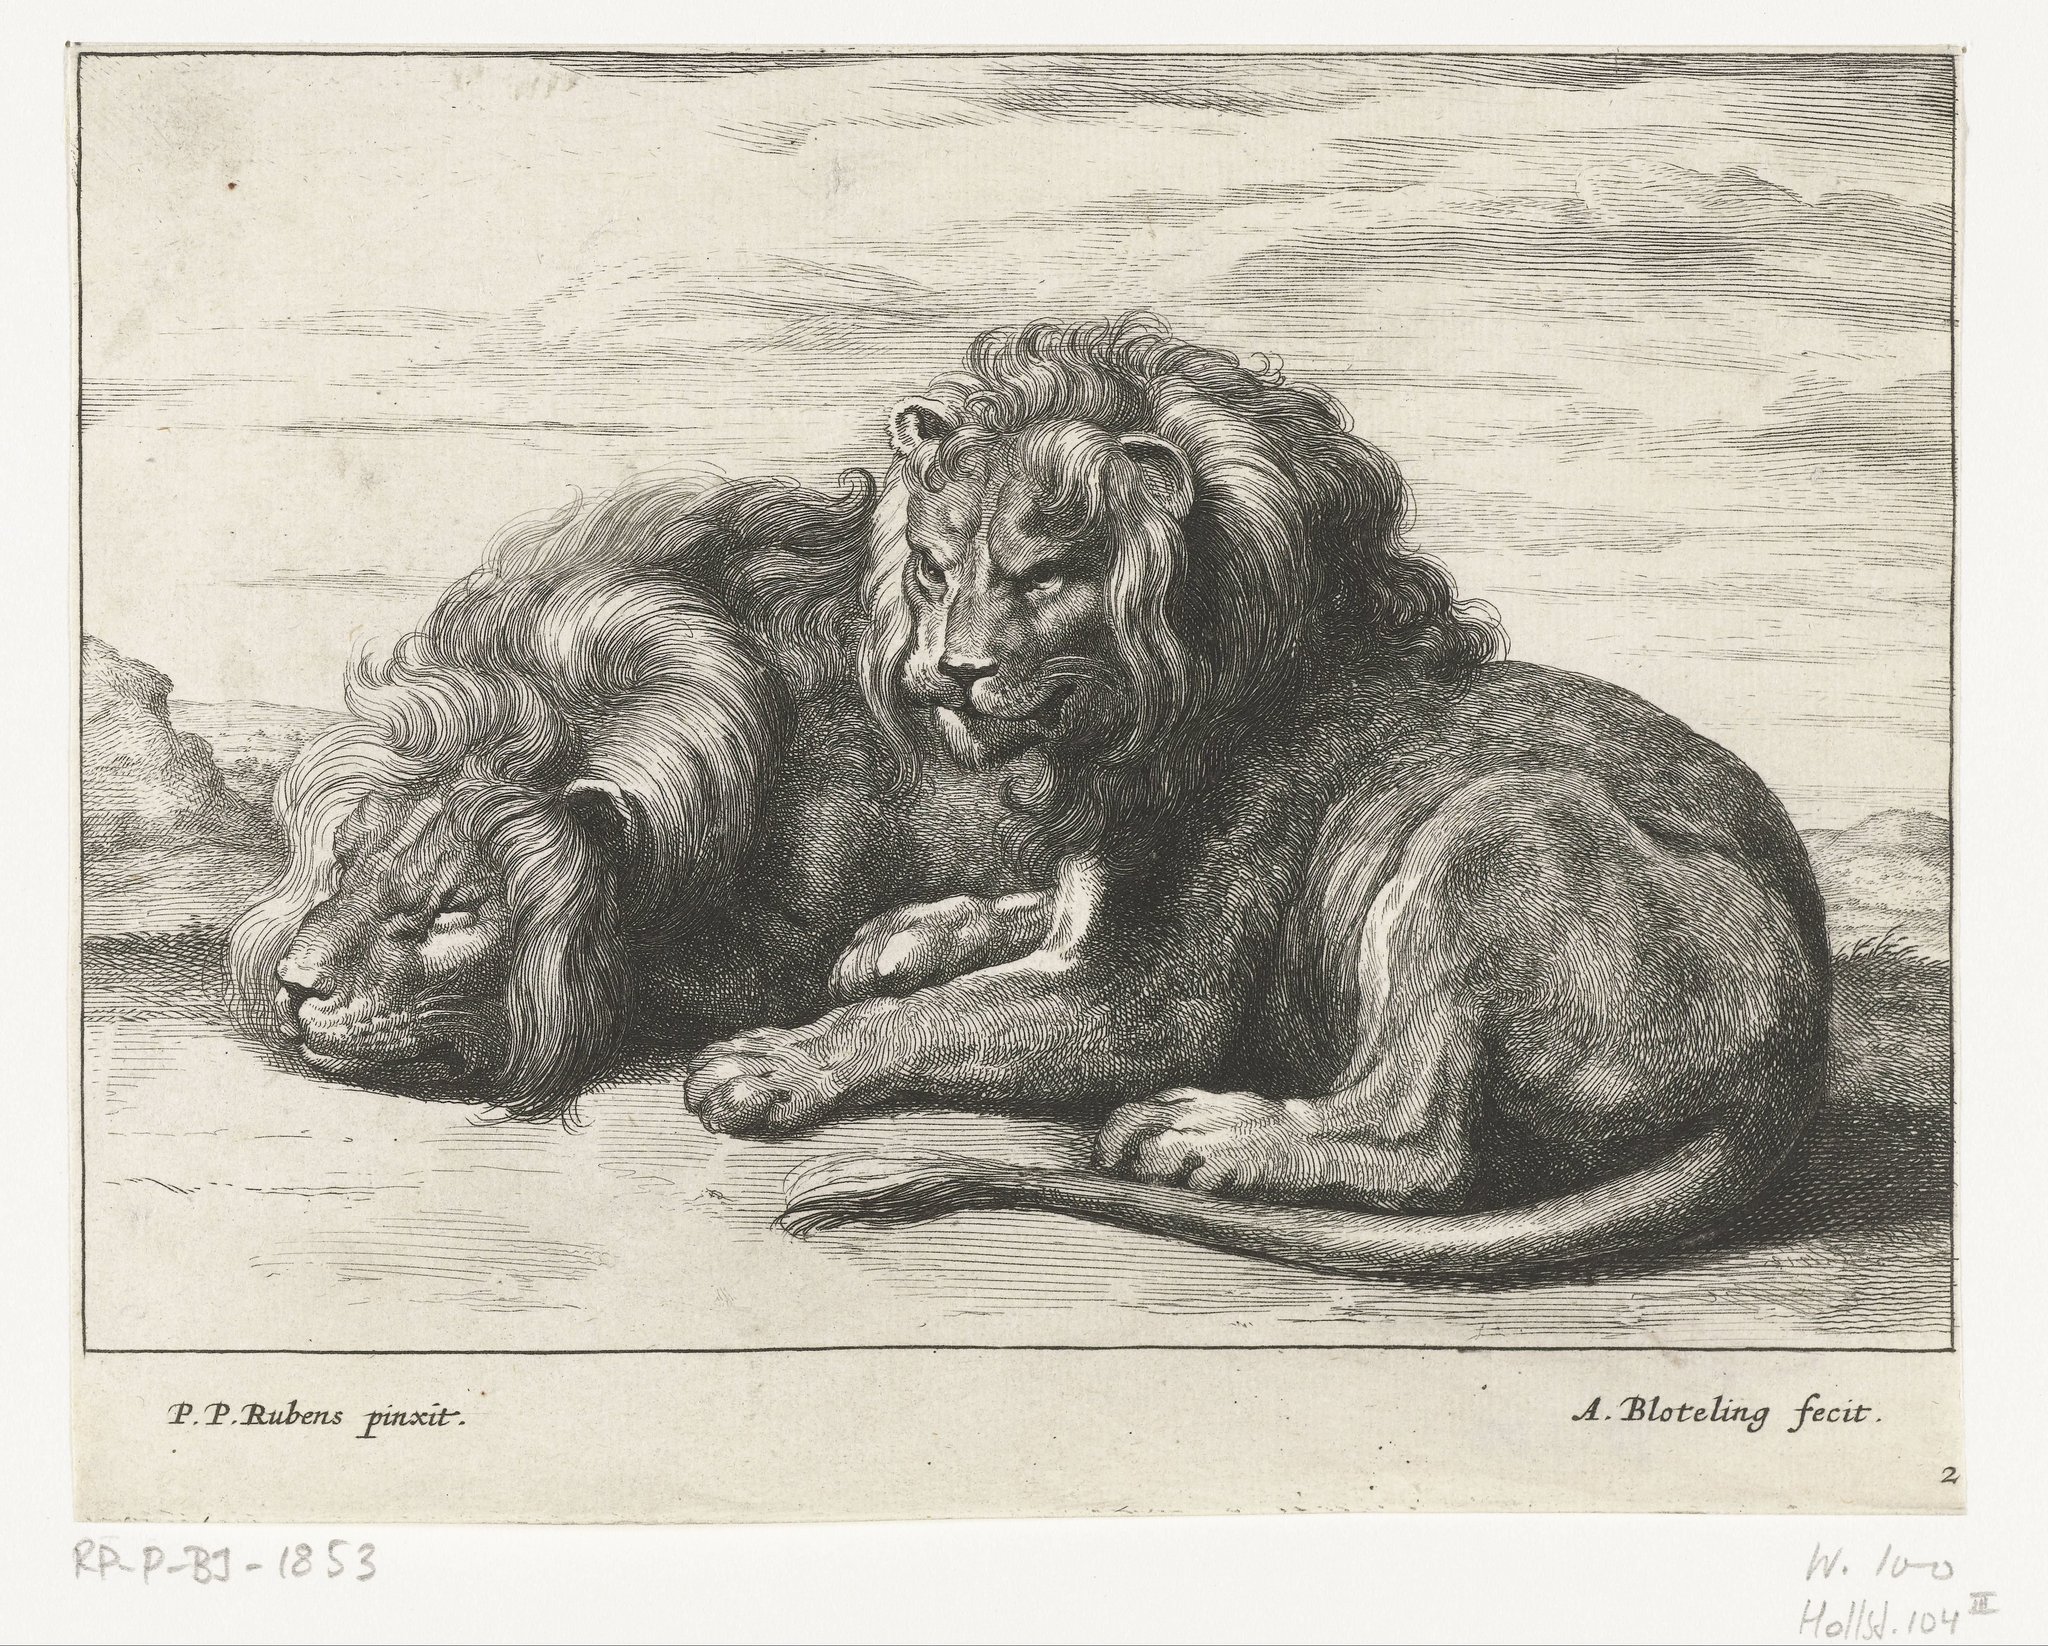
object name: print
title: Variæ leonum Icones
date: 1655-1690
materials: paper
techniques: etching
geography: amsterdam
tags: beasts of prey, predatory animals: lion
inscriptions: collector's mark: Lugt 240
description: Prent uit een serie van vier prenten met voorstellingen van leeuwen naar Pieter Paul Rubens.